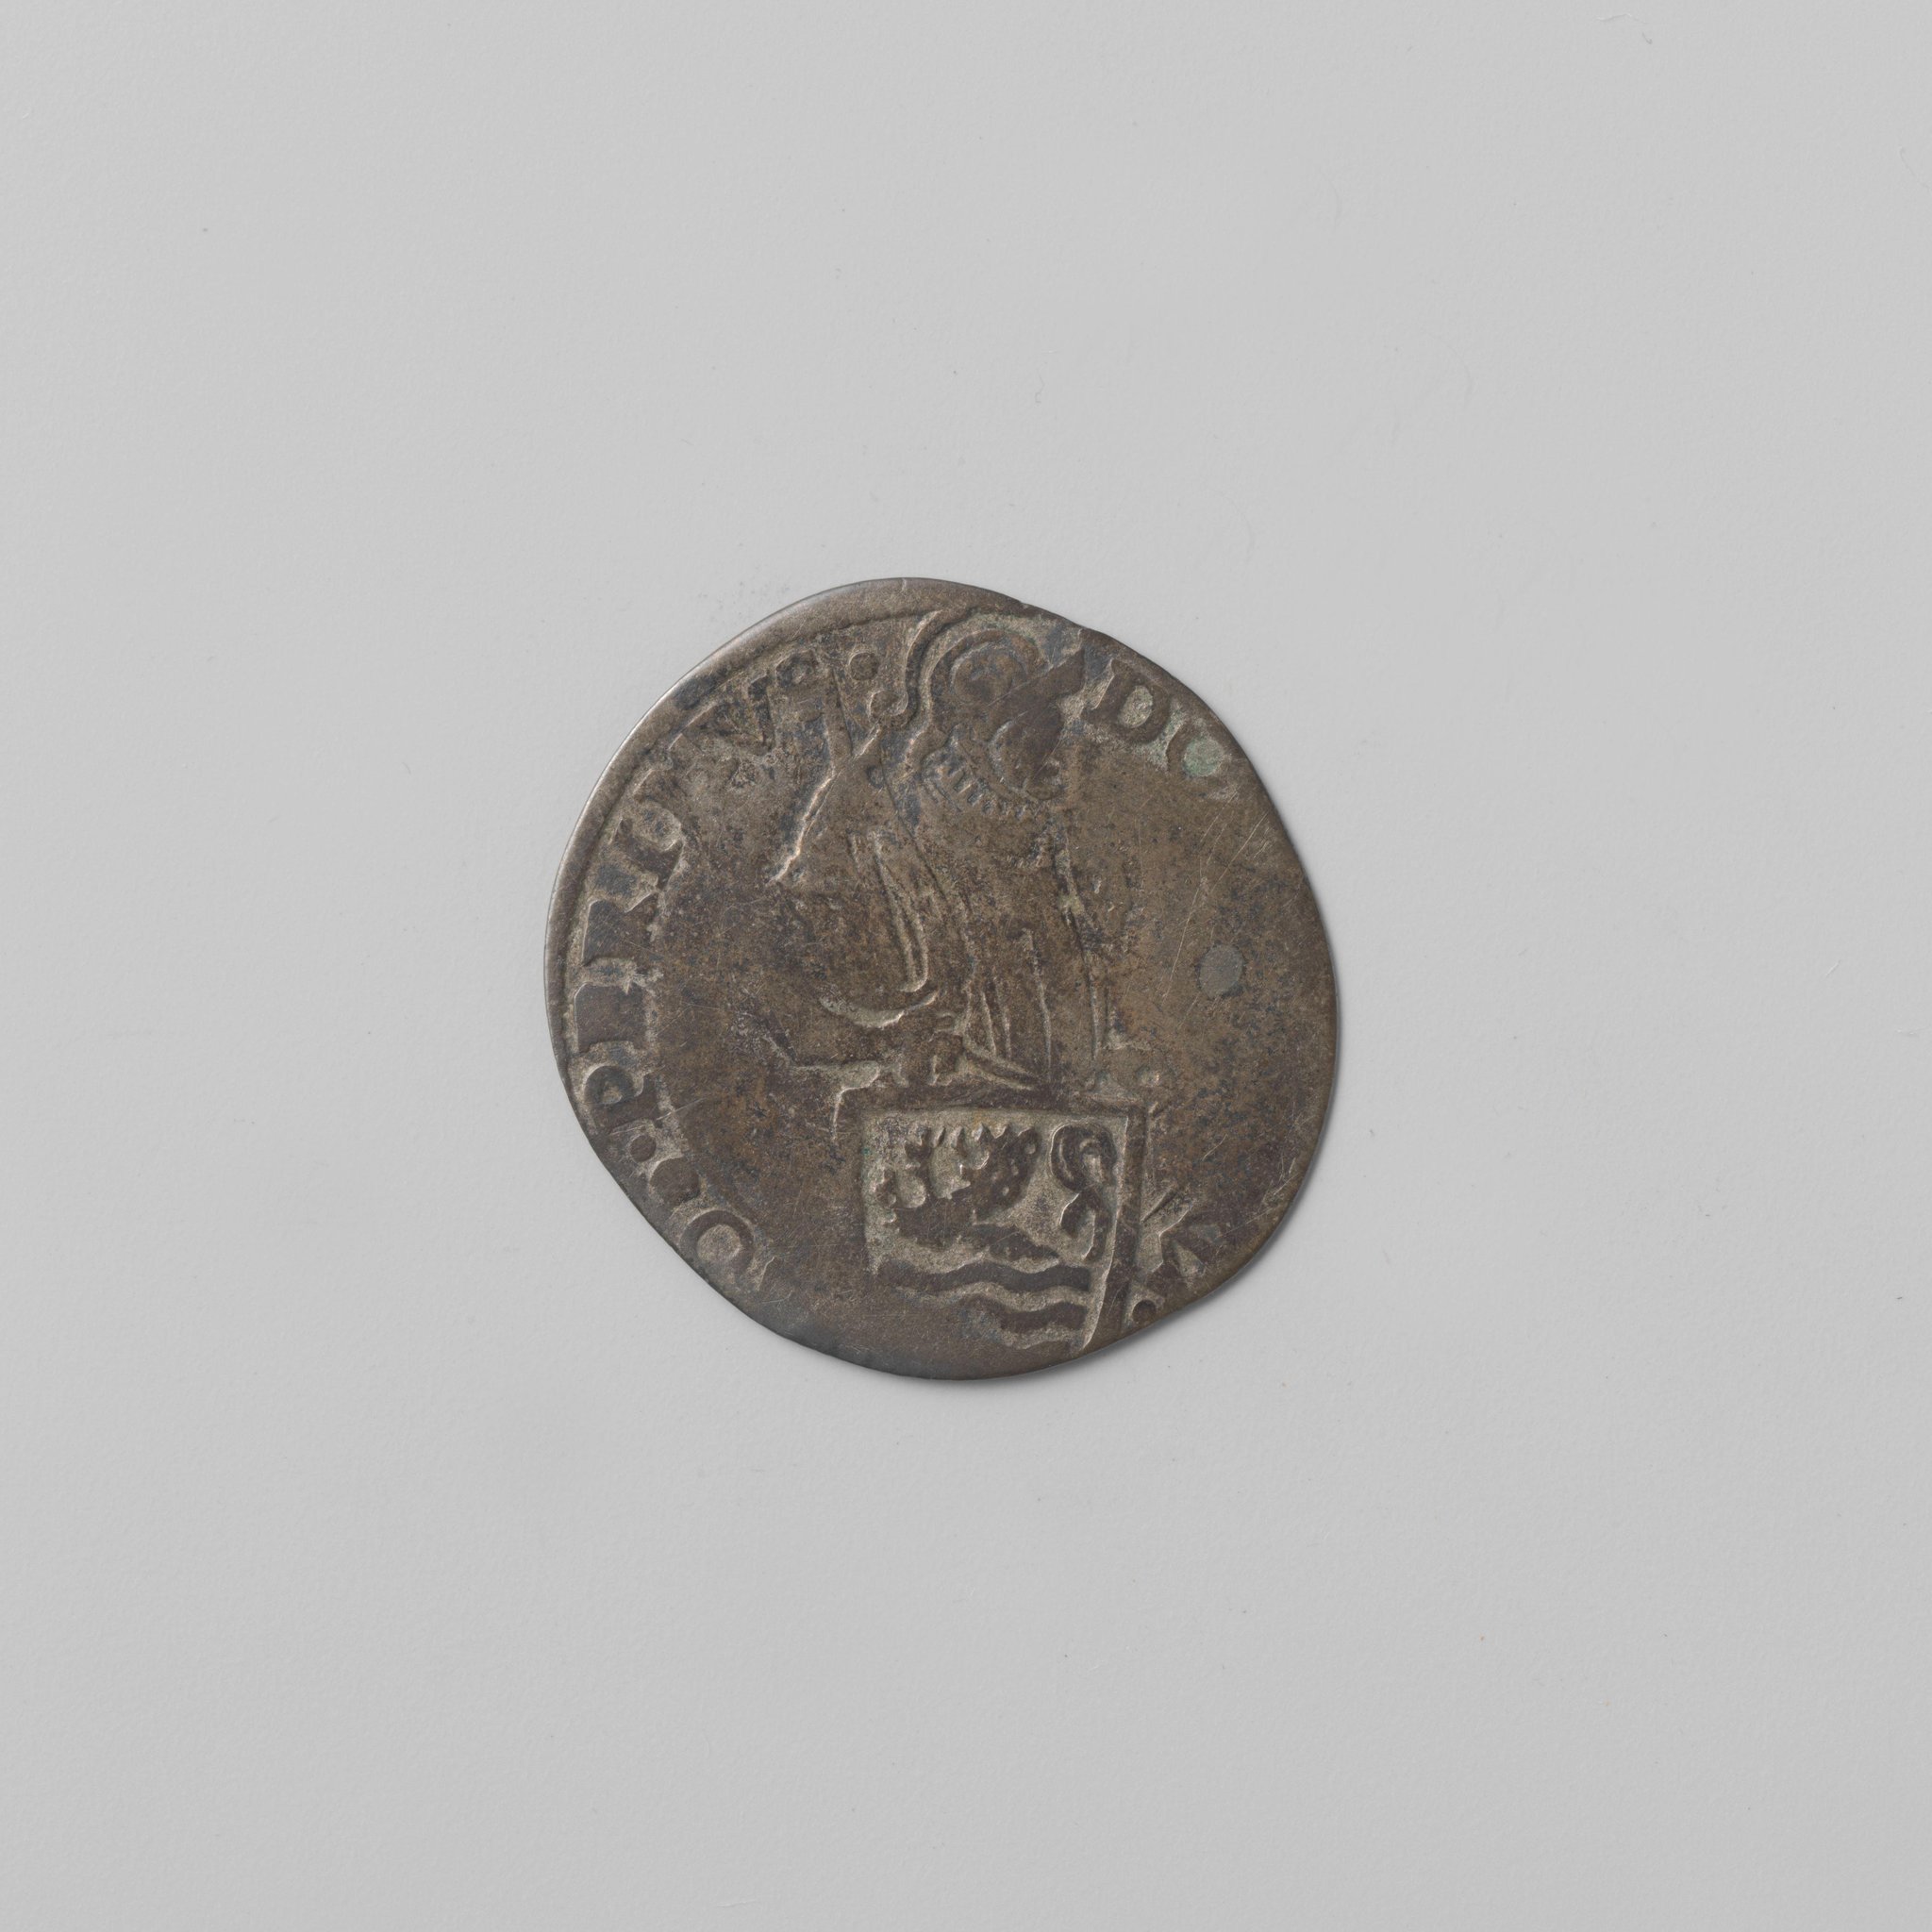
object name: coin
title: Zeeland, kwart snaphaanschelling, 1584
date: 1584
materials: silver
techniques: striking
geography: middelburg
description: Zilveren munt. Voorzijde: staande geharnaste ridder met zwaard en wapenschild van Zeeland voor zich. Keerzijde: kort versierd kruis met in het hart wapenschild van Zeeland, verkort jaartal 84 aan eind van omschrift.